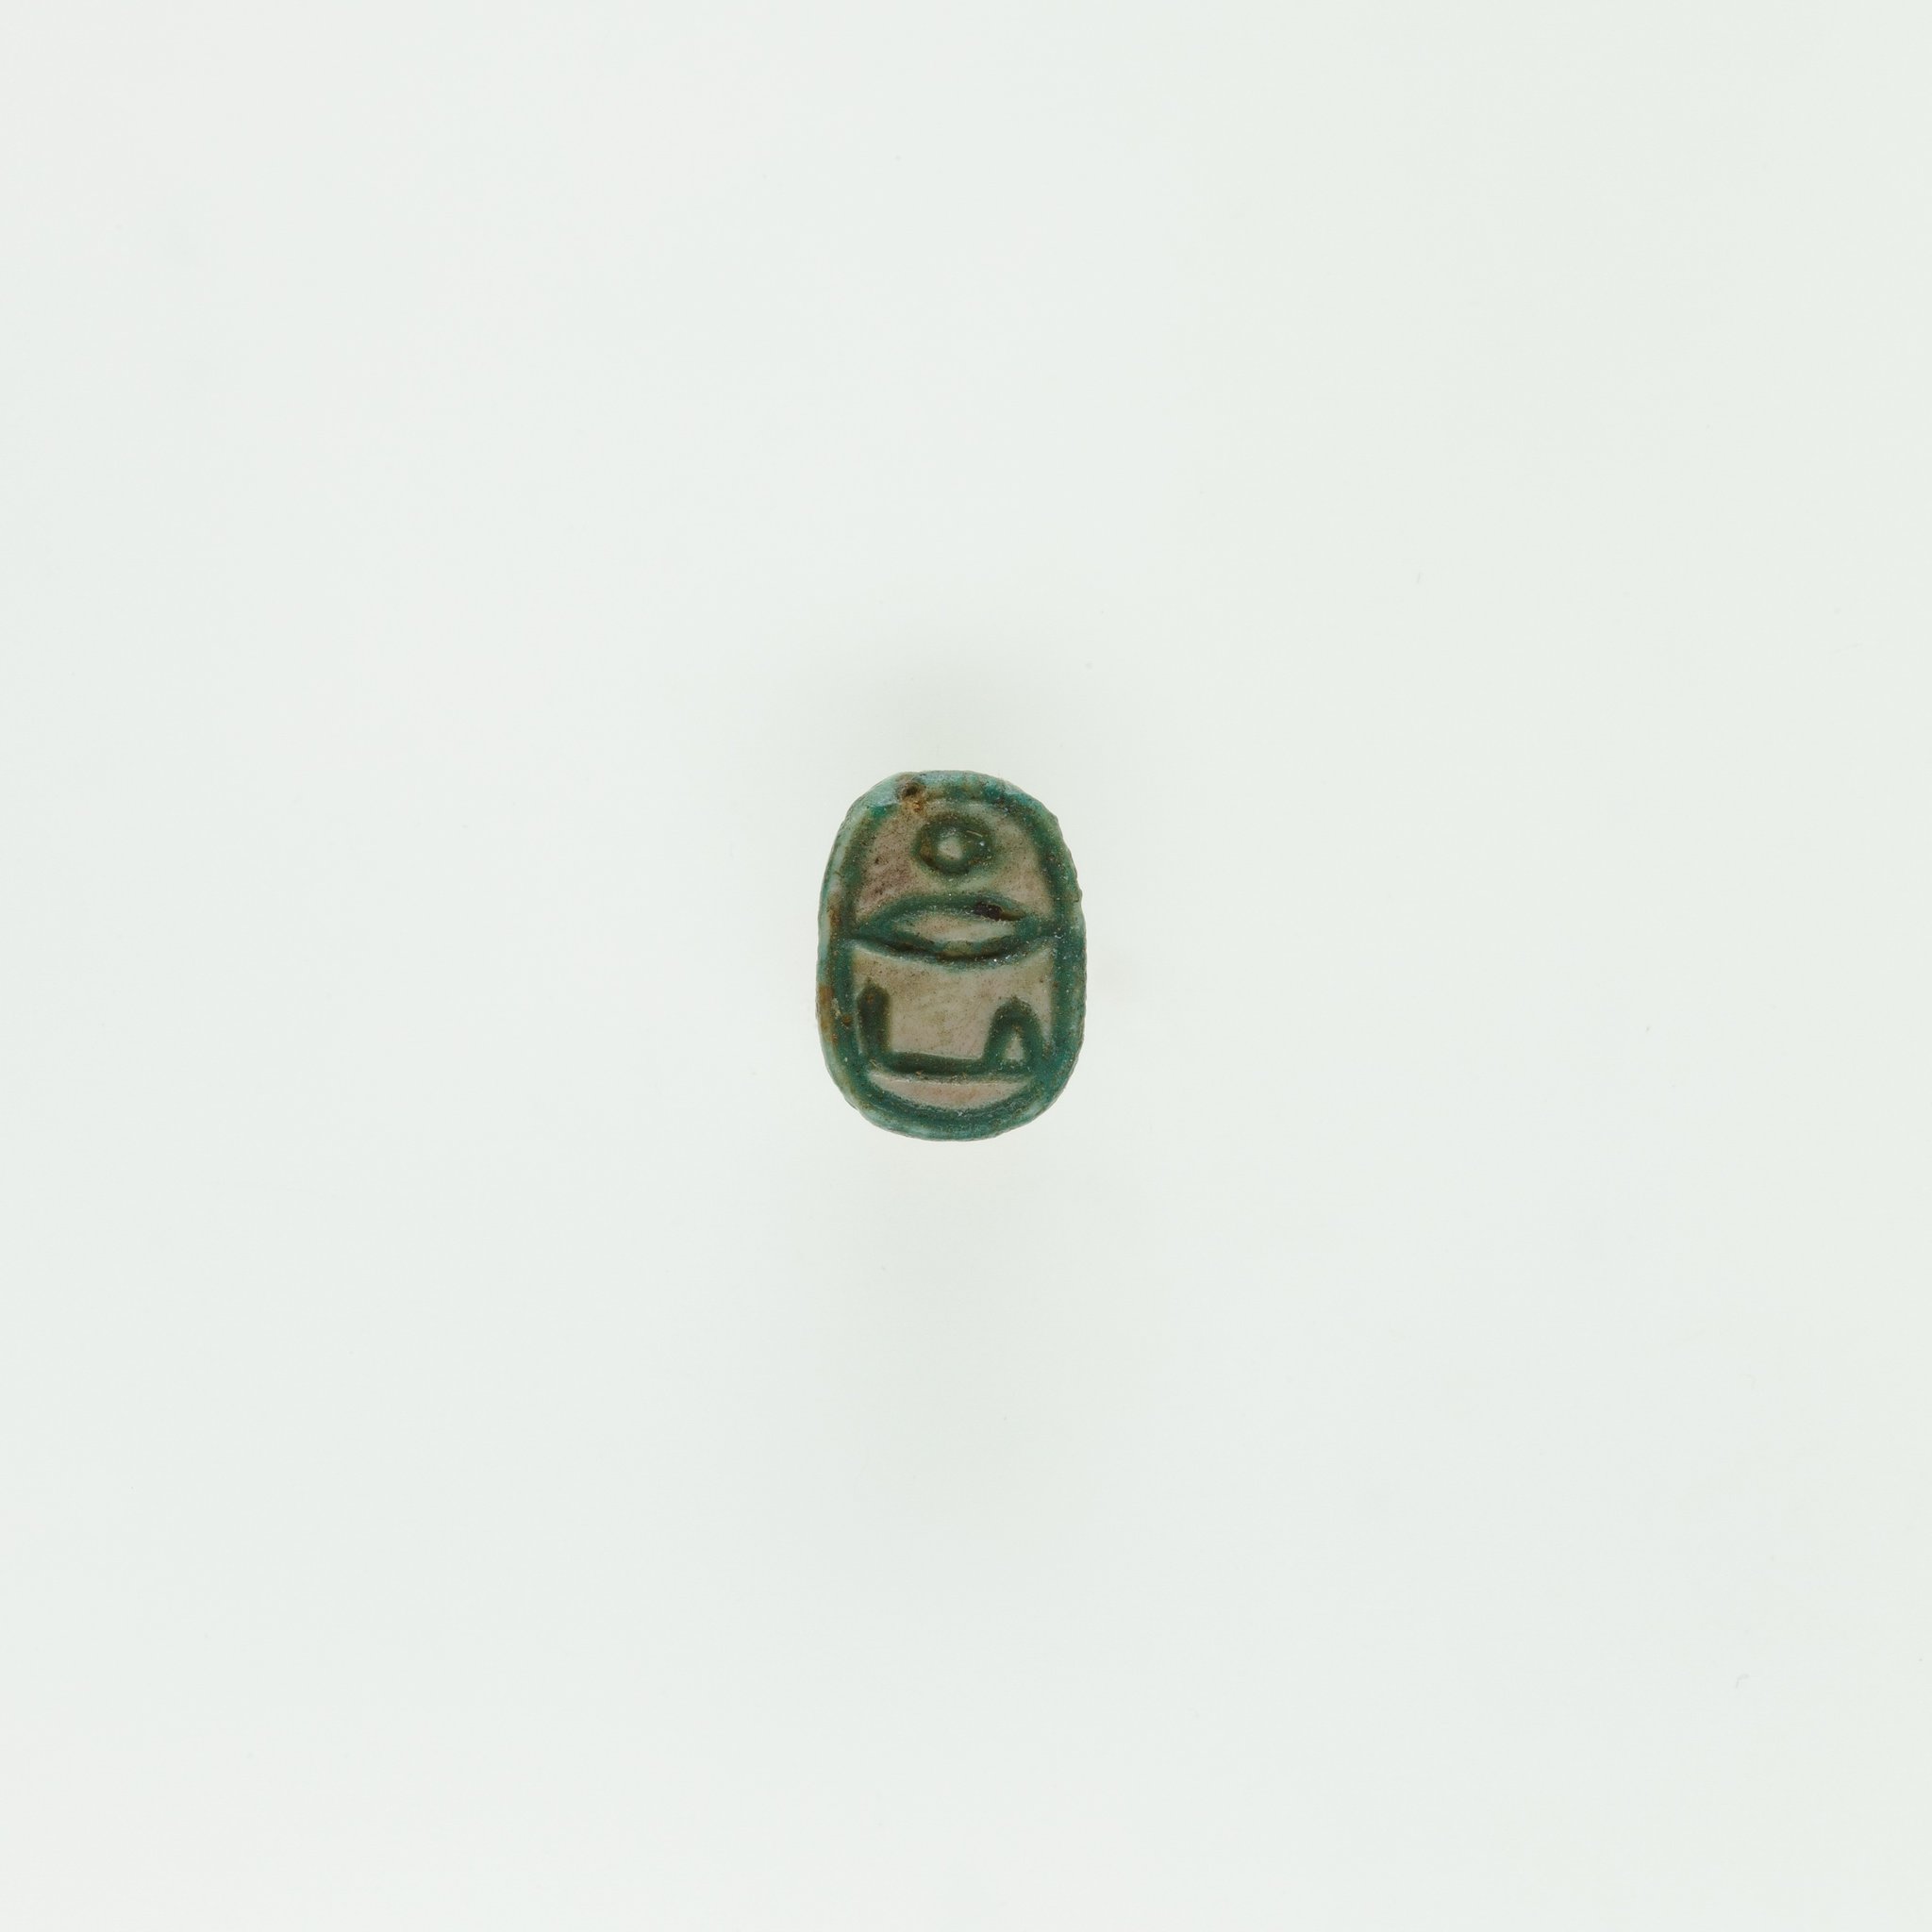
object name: scarab, may ra give, hieroglyph, re, rdi ra formula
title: Scarab Inscribed with a Blessing Related to Re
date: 1850-1640 BCE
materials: faience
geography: egypt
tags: scarabs